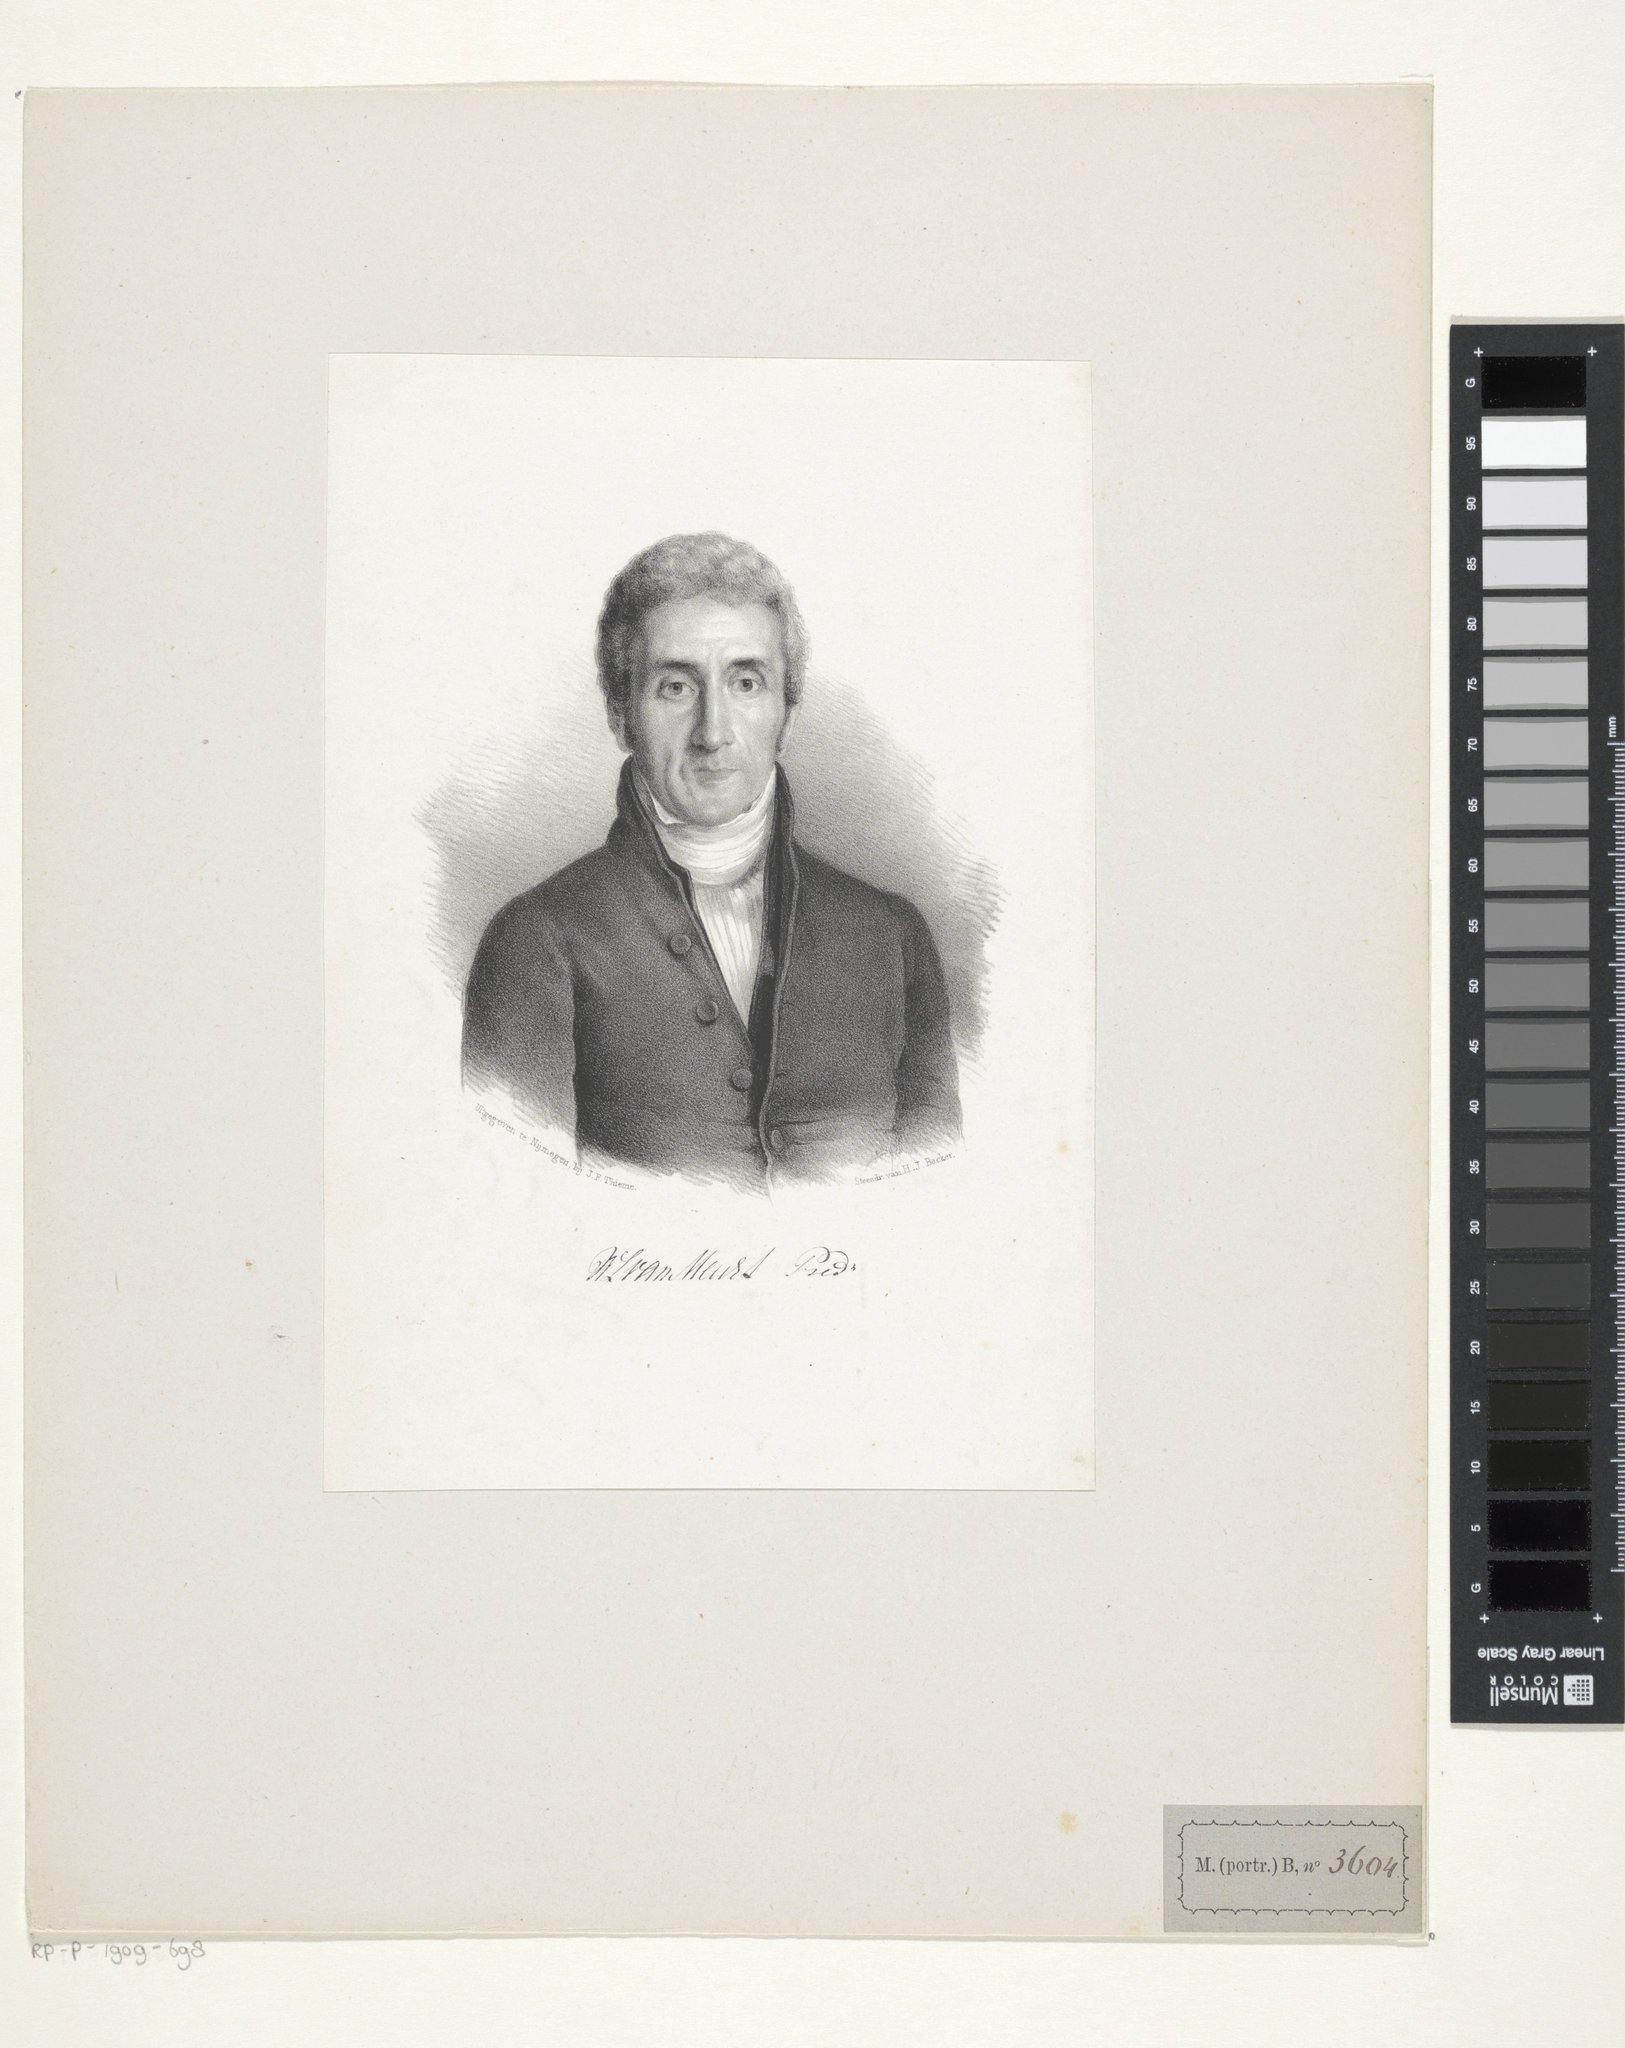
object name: print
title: Portret van Willem Lodewijk van Meurs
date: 1822-1845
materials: paper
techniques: lithograph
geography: nijmegen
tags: historical persons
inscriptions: collector's mark: Lugt 2228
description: Onder het portret de signatuur van de geportretteerde.